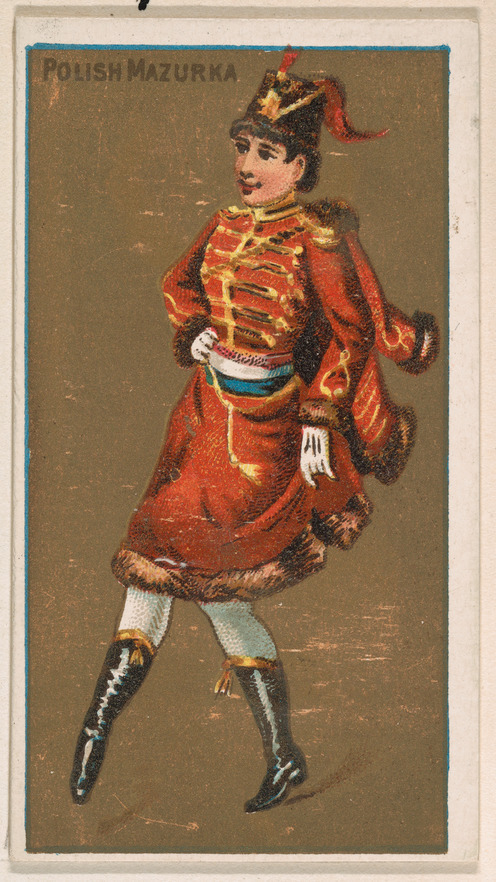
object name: print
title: Polish Mazurka, from National Dances (N225, Type 1) issued by Kinney Bros.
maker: kinney brothers tobacco company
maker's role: publisher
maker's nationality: american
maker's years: 1869-2011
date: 1889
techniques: color lithograph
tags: dance,women,dancers